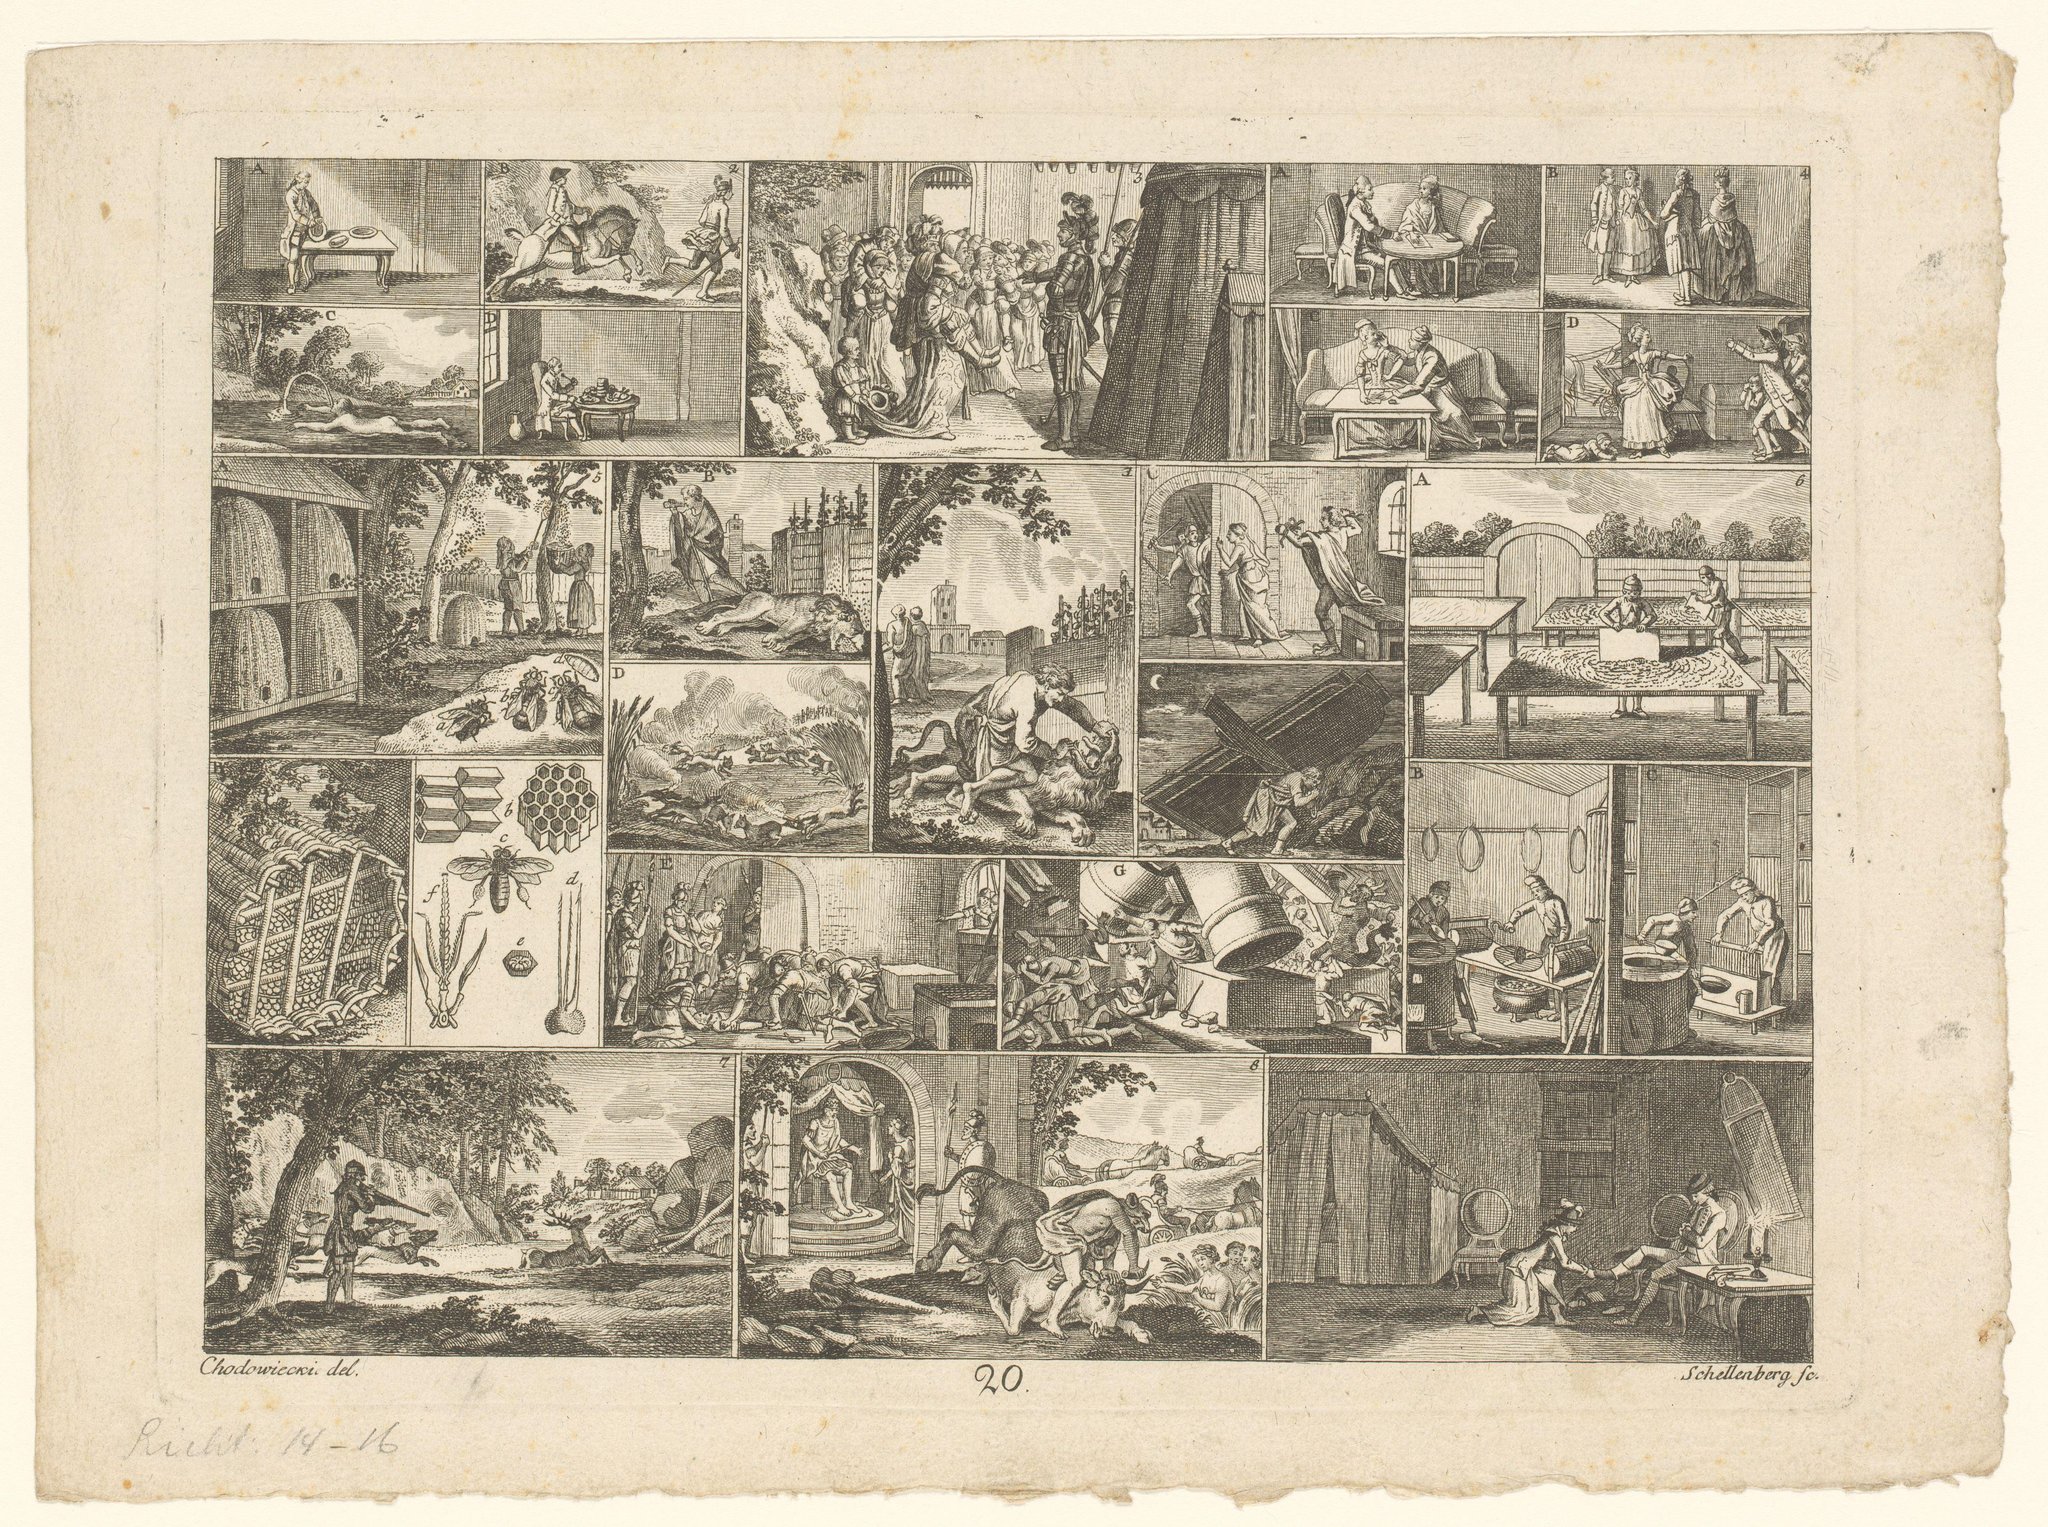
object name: print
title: Bilder-Akademie für die Jugend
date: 1784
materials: paper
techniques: engraving, etching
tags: samson kills the lion with his bare hands, (7) the cretan bull is captured by hercules, bee-hive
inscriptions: collector's mark: Lugt 2228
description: Maakt deel uit van een serie encyclopedische prenten door verschillende kunstenaars naar ontwerp van Daniel Nikolaus Chodowiecki bij Johann Sigmund Stoy's 'Bilder-Akademie für die Jugend', uitgegeven te Neurenberg in 1784. De prenten waren bedoeld voor kinderen om uit te knippen, op kaarten te plakken en vervolgens op logische wijze te rangschikken (zie Heesen, Anke te. The World in a Box: The Story of an Eighteenth-Century Picture Encyclopedia. Chicago: University of Chicago Press, 2002).